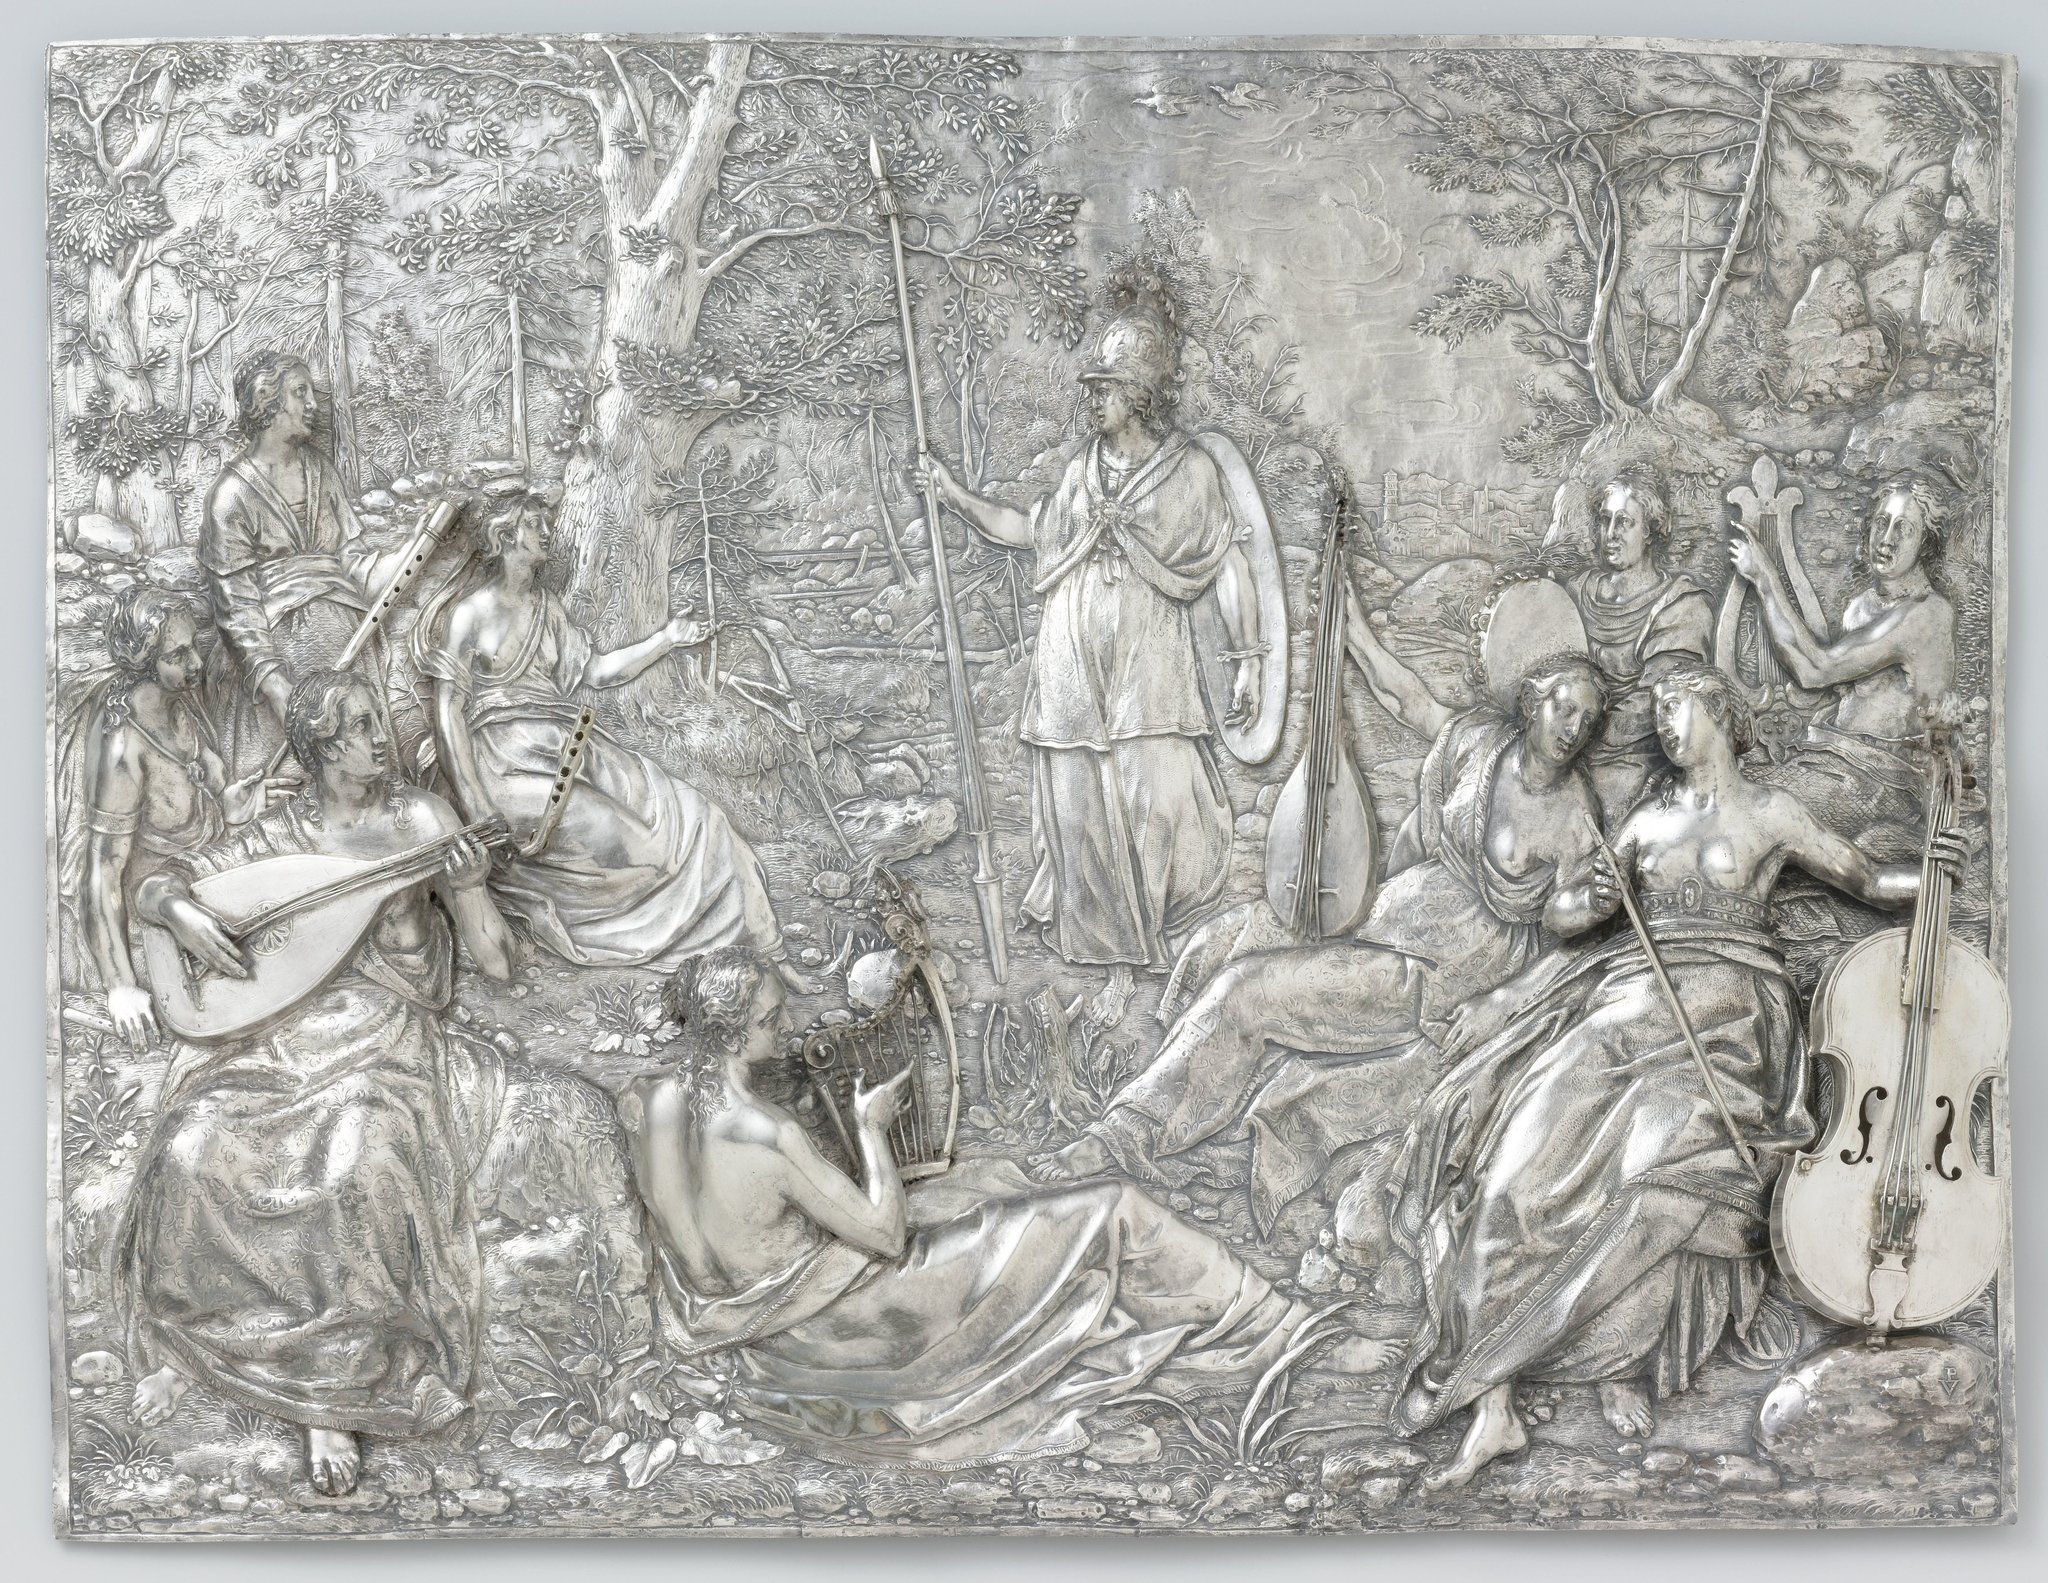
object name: plaque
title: Minerva and the Muses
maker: paulus willemsz. van vianen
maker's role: draughtsman, jeweler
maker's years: 1570-1614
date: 1604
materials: silver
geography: prague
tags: (story of) minerva (pallas, athena), the muses acting together (as group)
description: Paulus van Vianen often derived the subject of his plaquettes from Ovid’s Metamorphoses, as is the case here. The goddess Minerva visits the Muses because she wishes to see the sacred spring that the winged horse Pegasus caused to gush forth near them with a blow of his hoof.